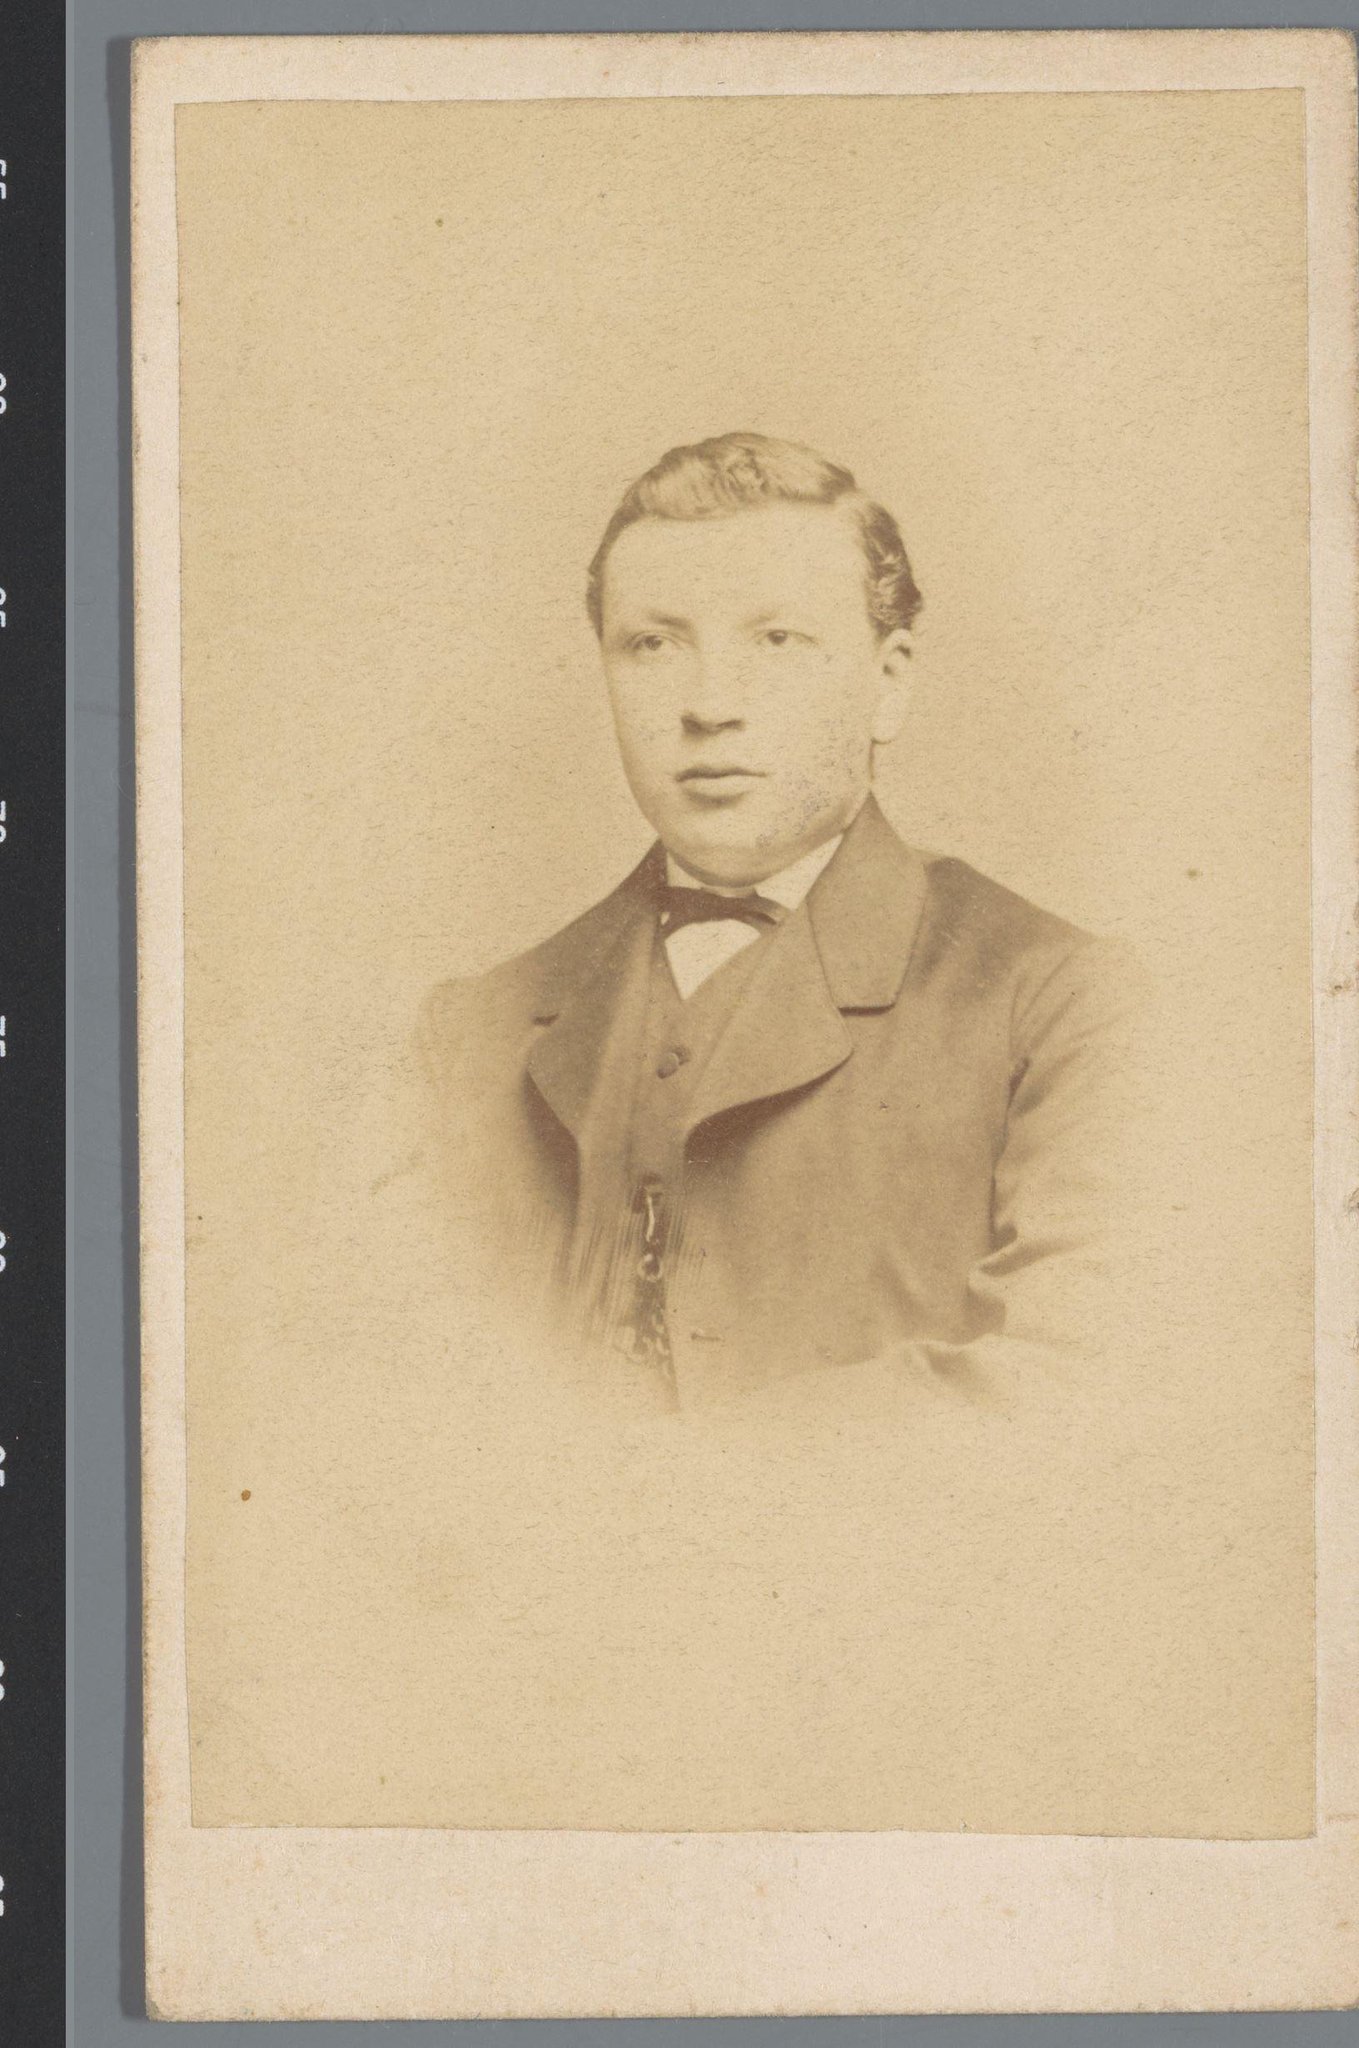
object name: photograph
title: Portret van een onbekende man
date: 1868-1869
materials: cardboard, paper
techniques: albumen print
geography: utrecht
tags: adult man, anonymous historical person portrayed, utrecht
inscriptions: inscription: ‘Photographisch Atelier/ F.W. Busch en Comp./ Lijnmarkt No. 70./ Utrecht.’